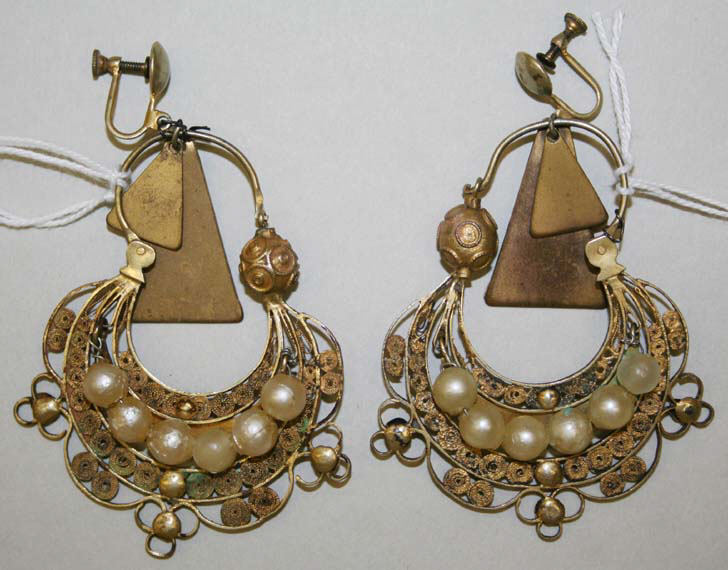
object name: earring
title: Earrings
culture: spanish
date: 1801-1900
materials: metal, pearl